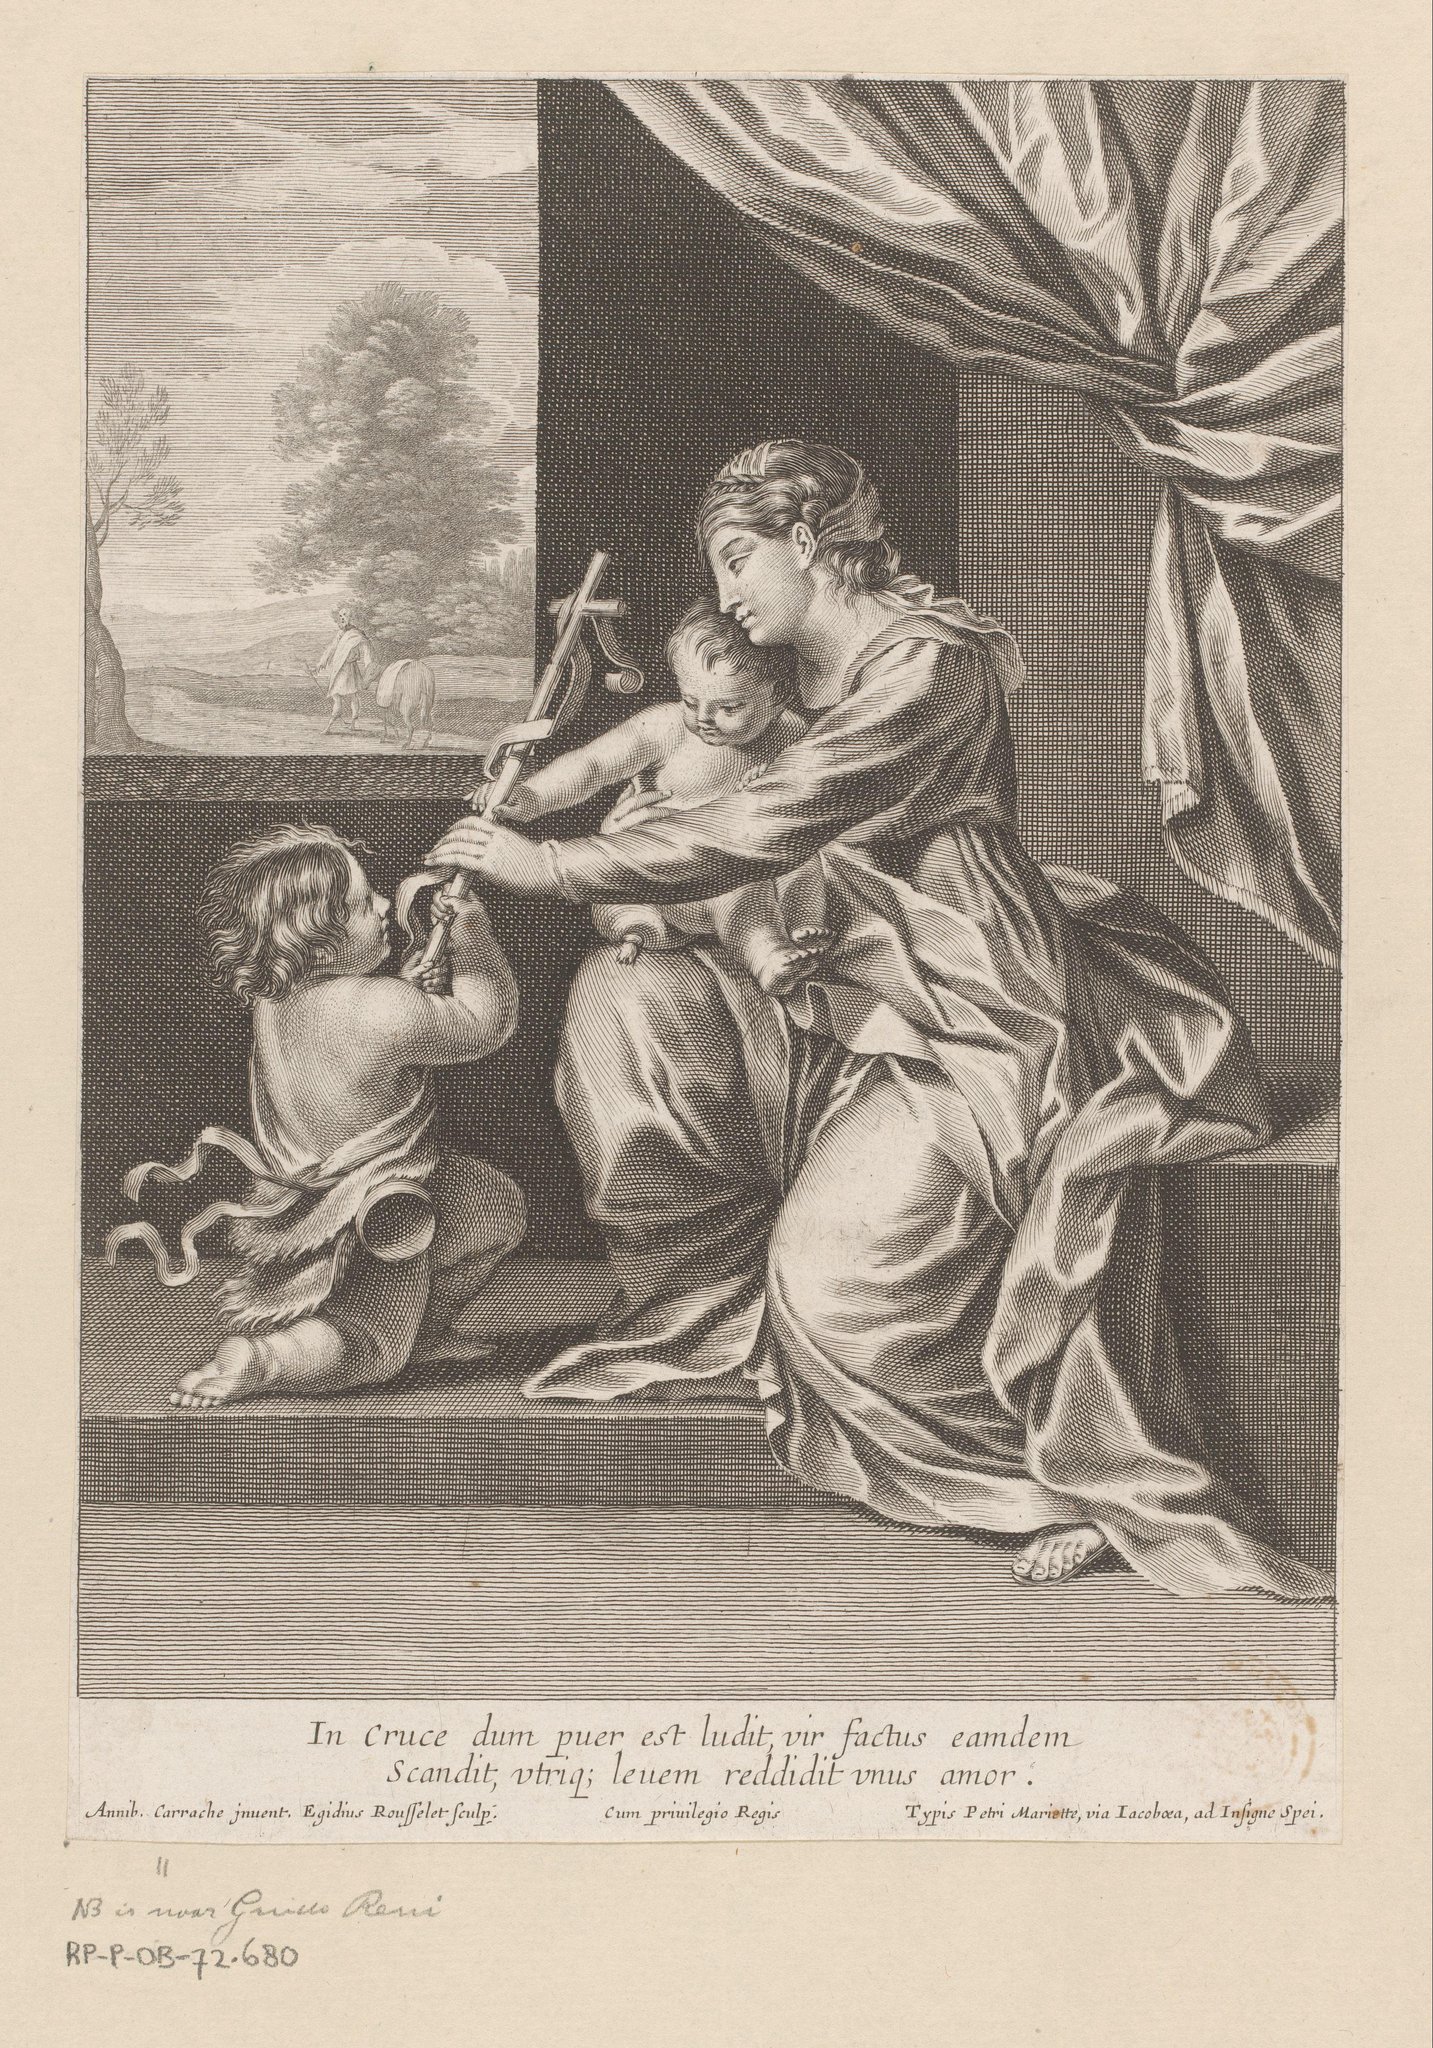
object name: print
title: Maria met kind en Johannes de Doper die een kruis aanreikt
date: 1654-1656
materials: paper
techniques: engraving, etching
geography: france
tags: mary and the christ-child with john the baptist (as child)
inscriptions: collector's mark: Lugt 240